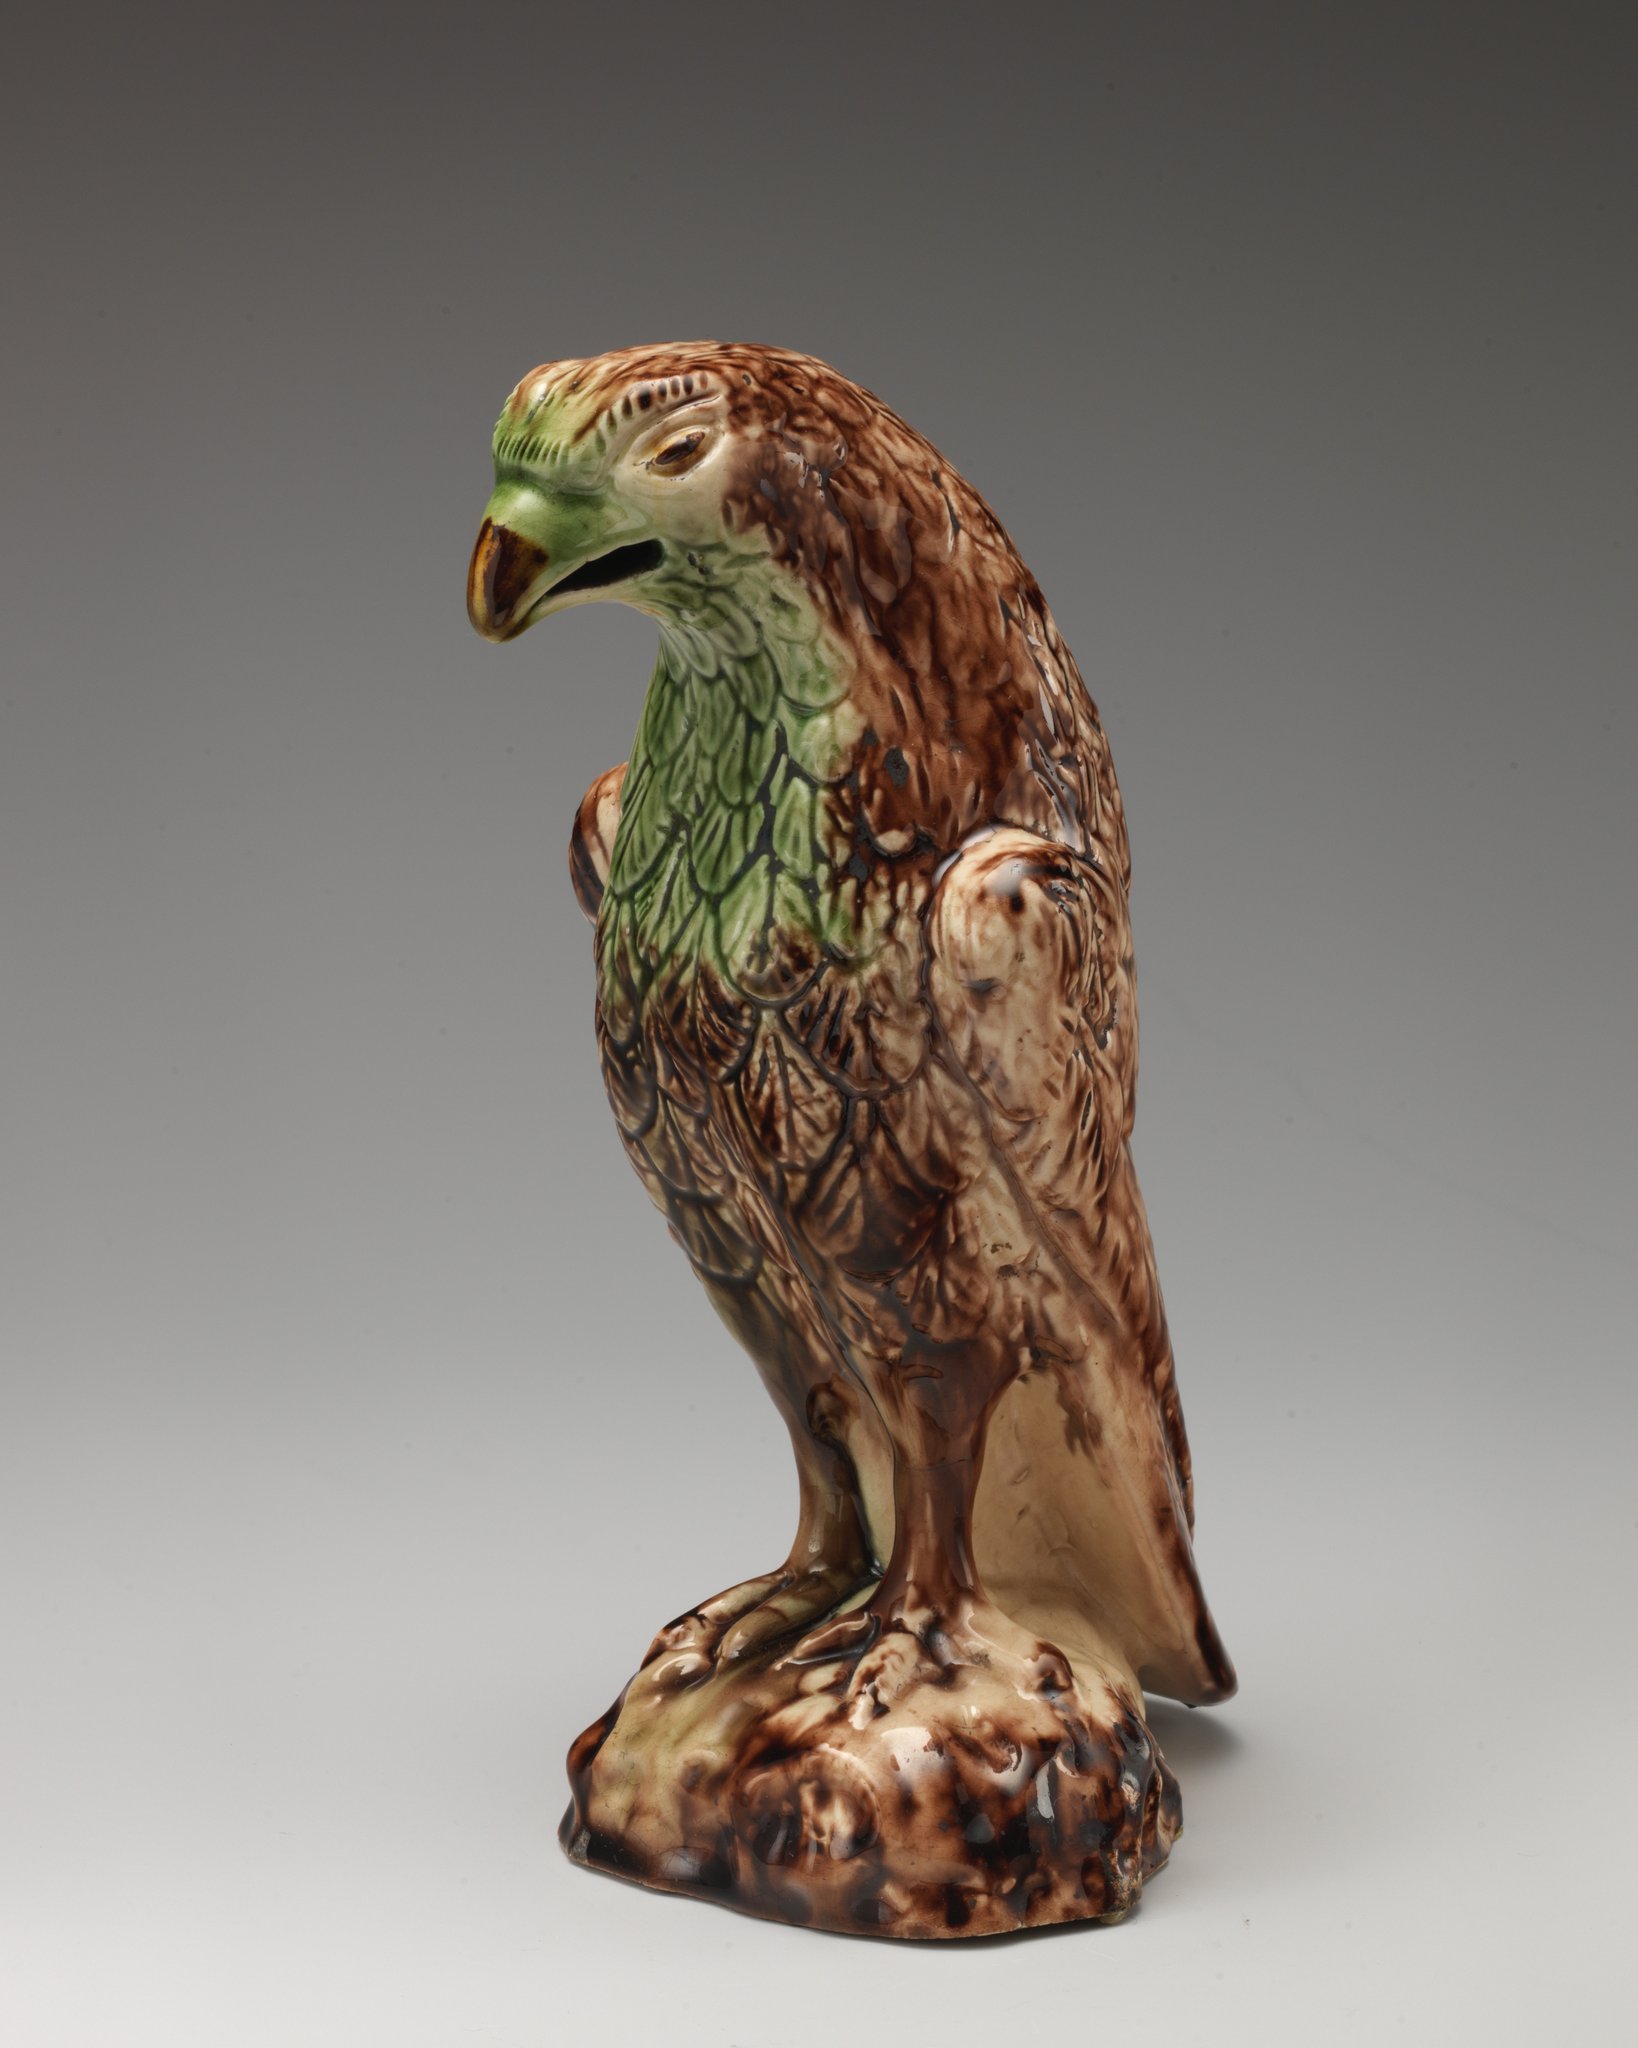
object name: figure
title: Hawk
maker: whieldon type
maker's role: maker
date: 1750-1760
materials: earthenware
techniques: glazing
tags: hawks